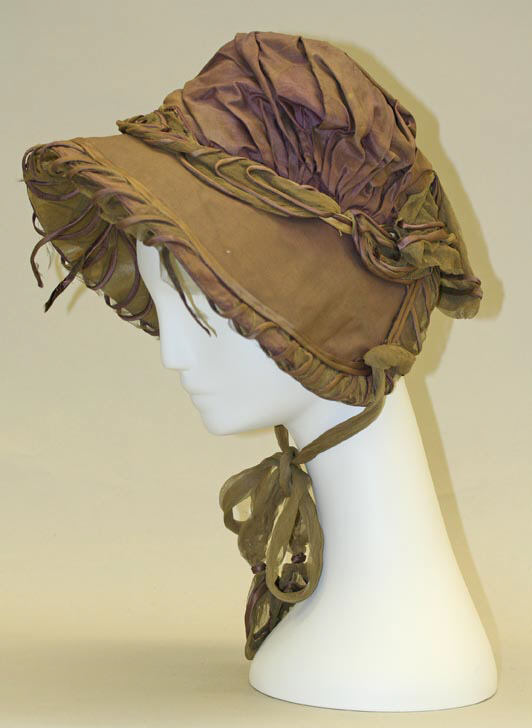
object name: bonnet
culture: italian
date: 1820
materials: silk